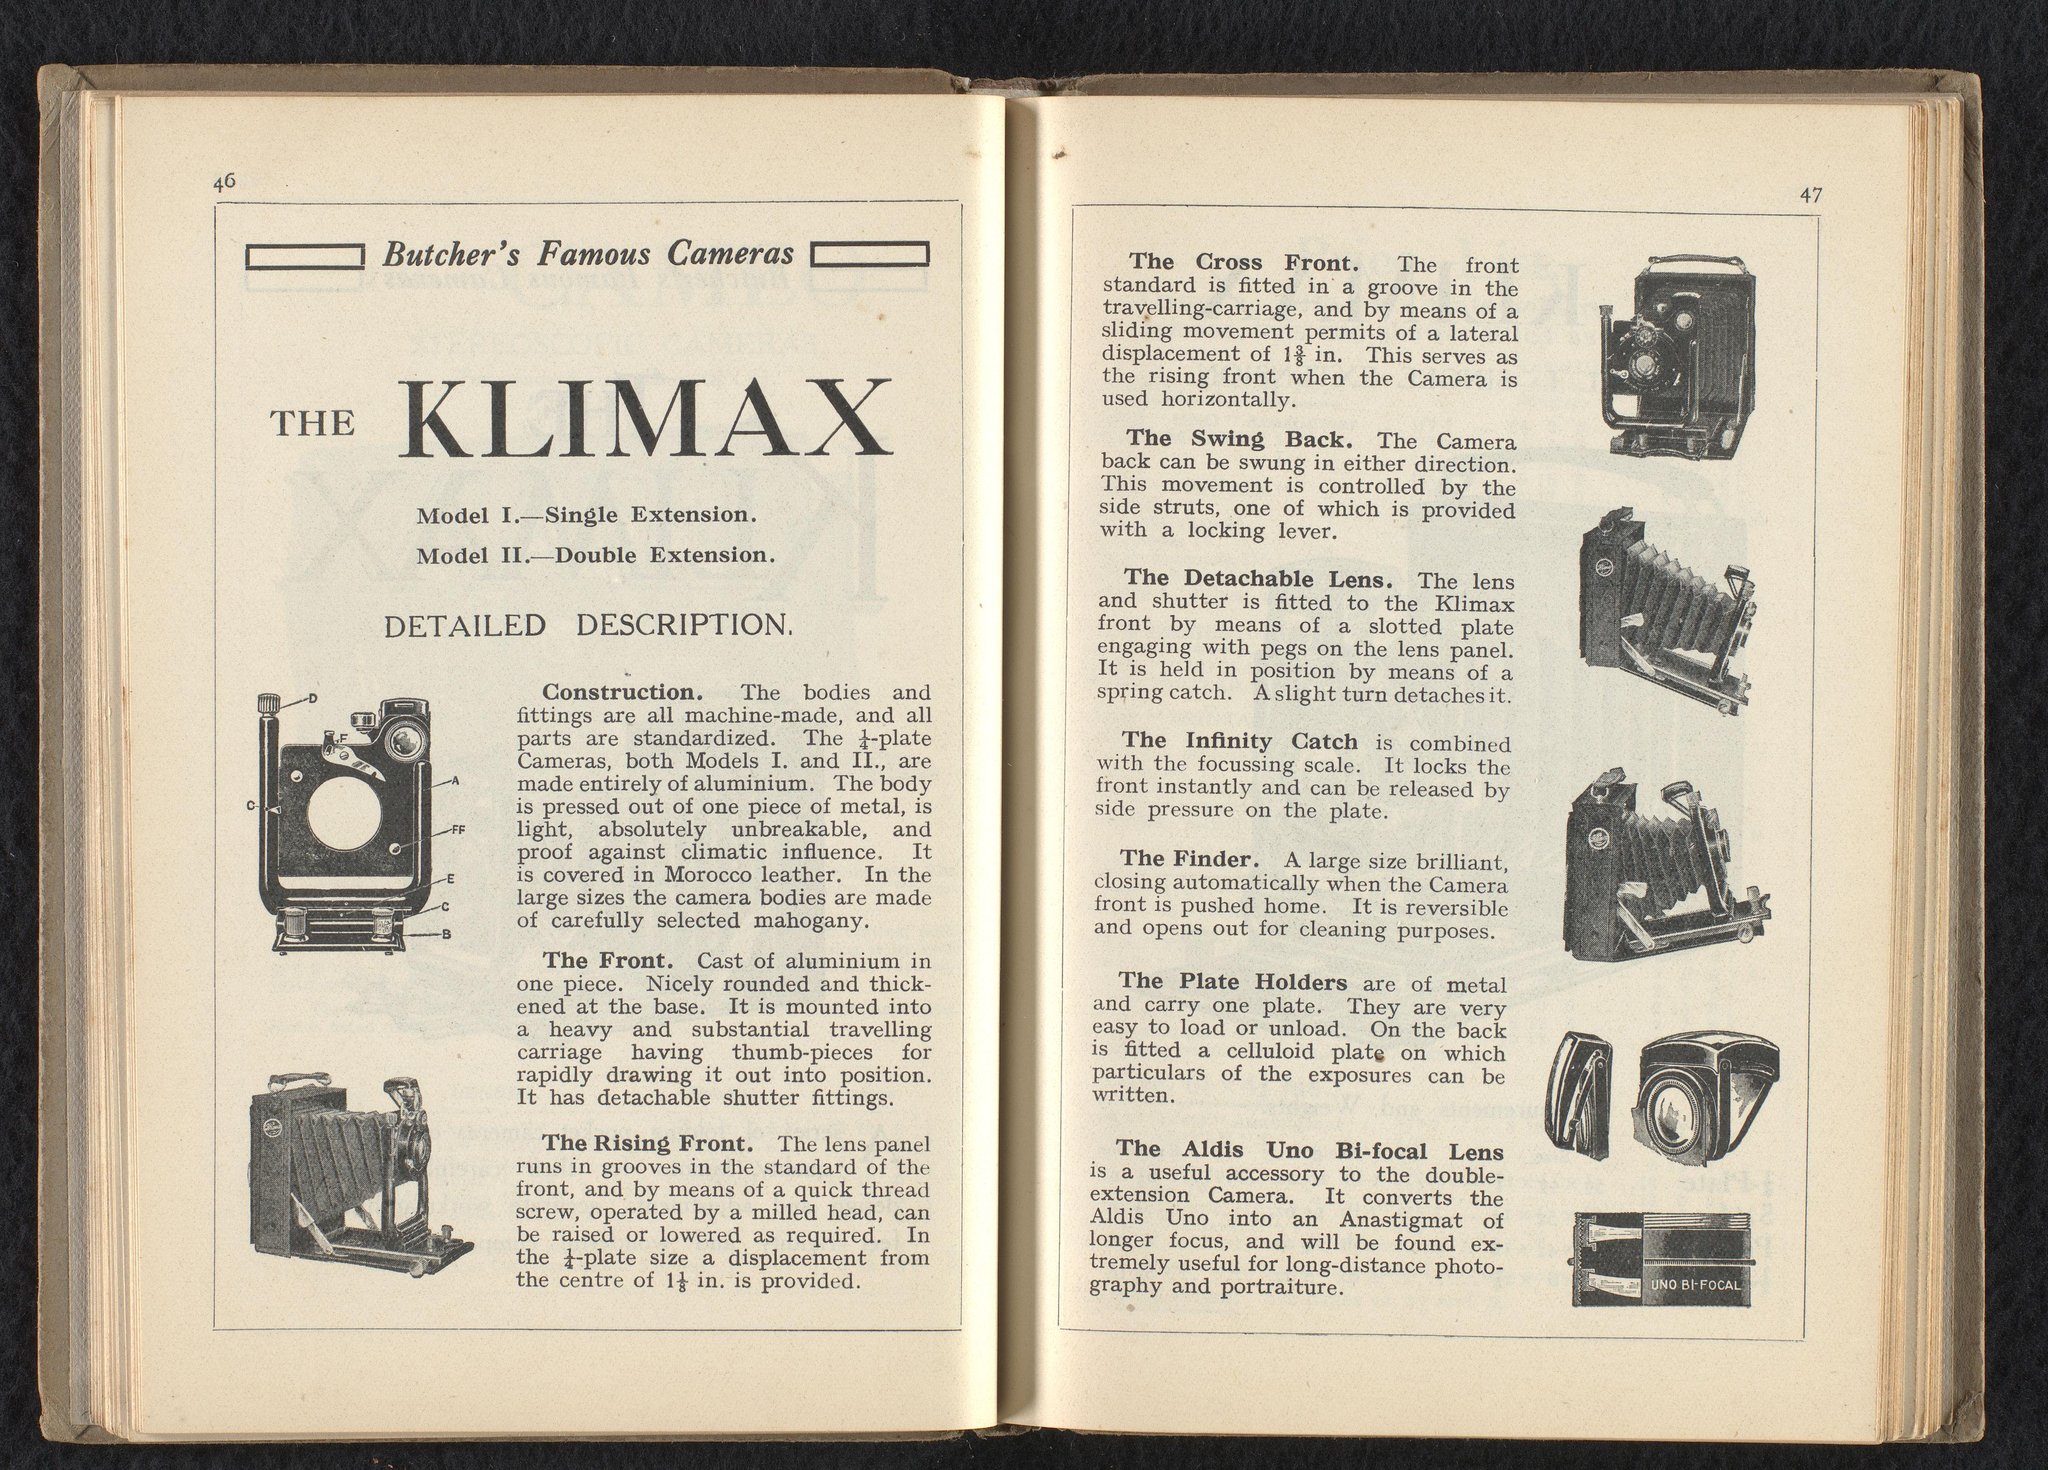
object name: page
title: Uitgevouwen Klimax camera in verschillende standen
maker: Anonymous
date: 1907-1912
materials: paper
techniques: letterpress printing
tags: camera ~ photography